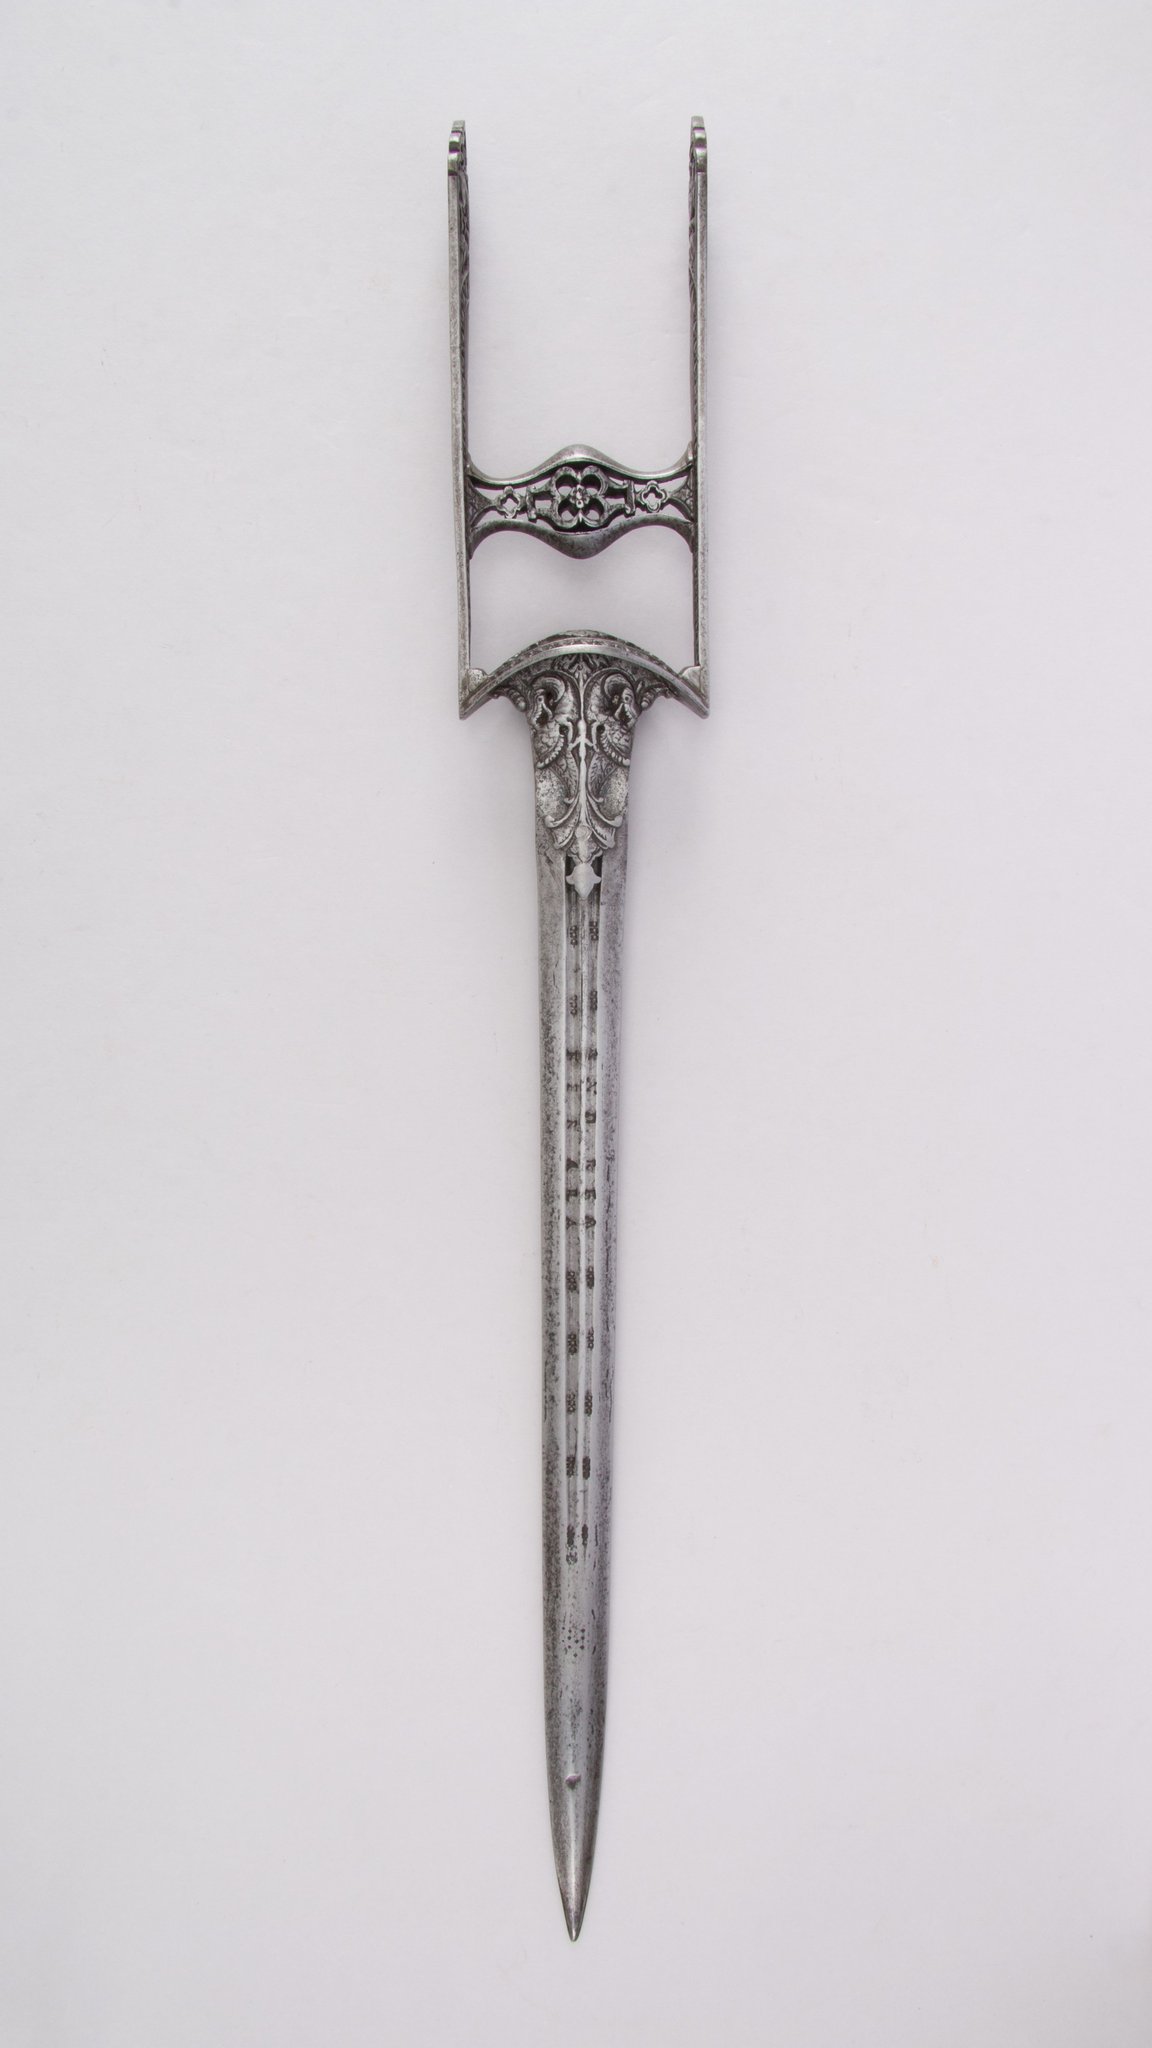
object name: dagger katar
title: Dagger (Katar)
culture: indian or european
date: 1601-1700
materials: steel